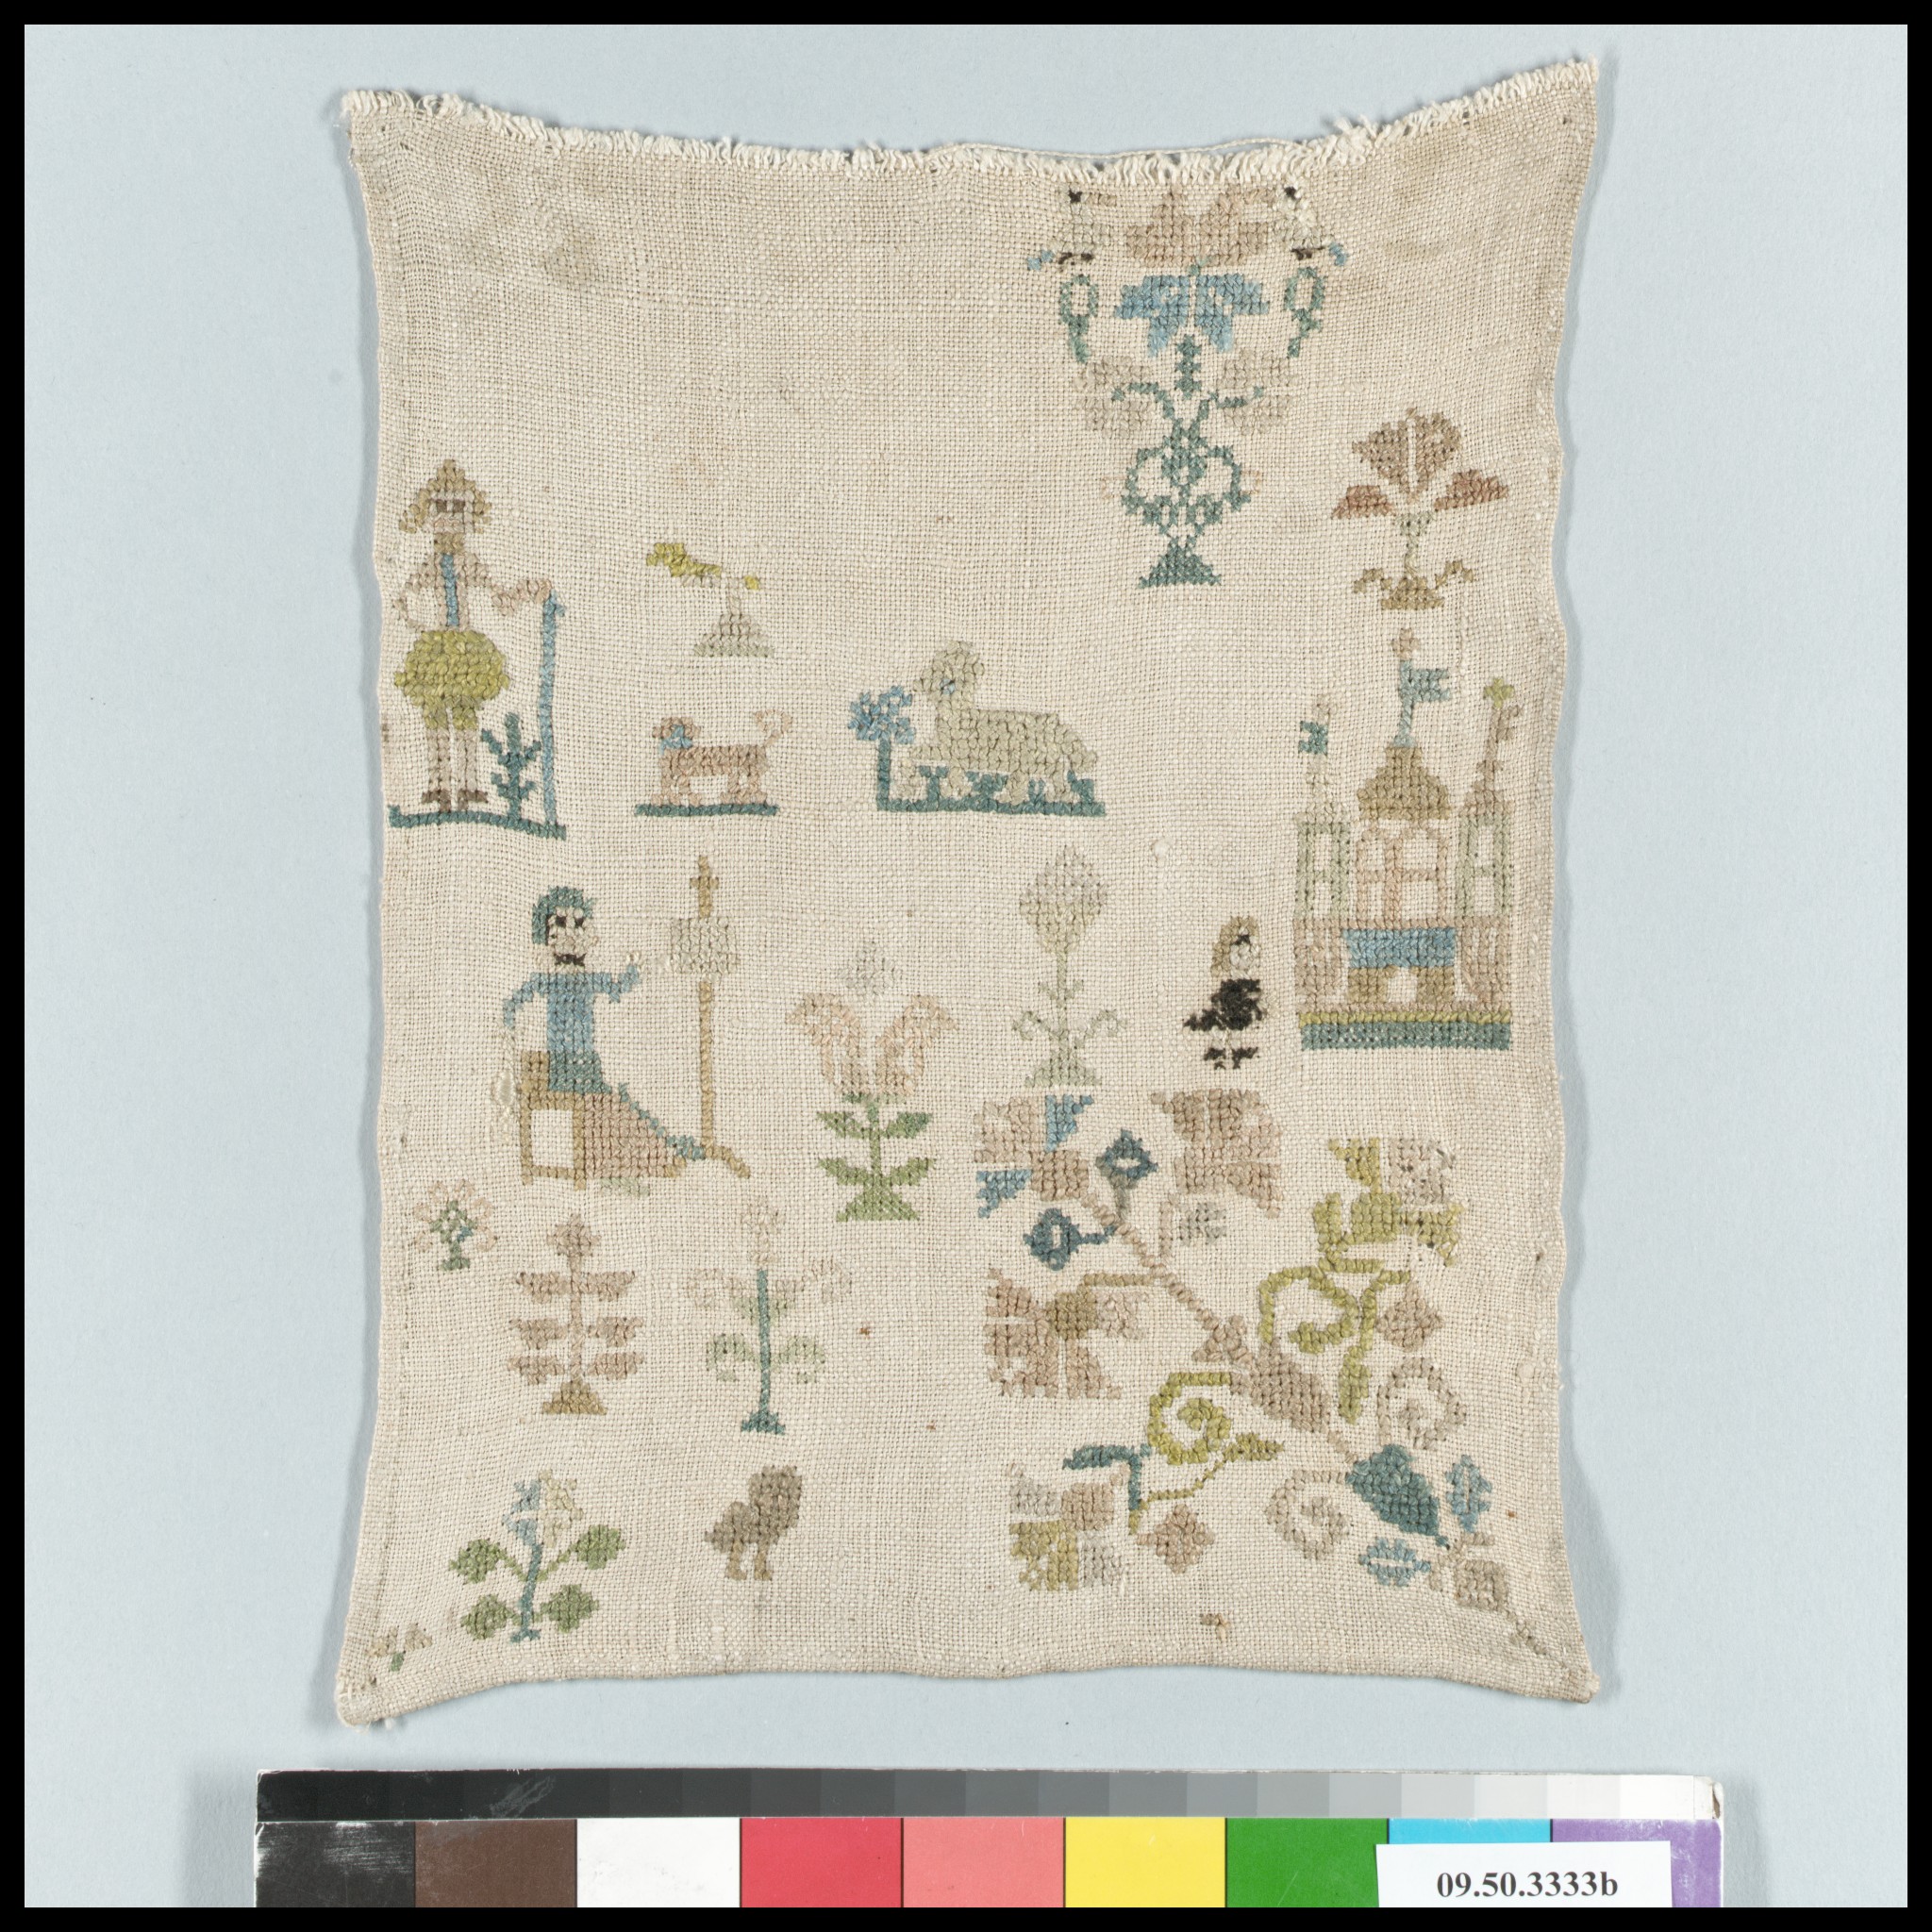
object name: sampler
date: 1701-1800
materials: linen, silk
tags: human figures,animals